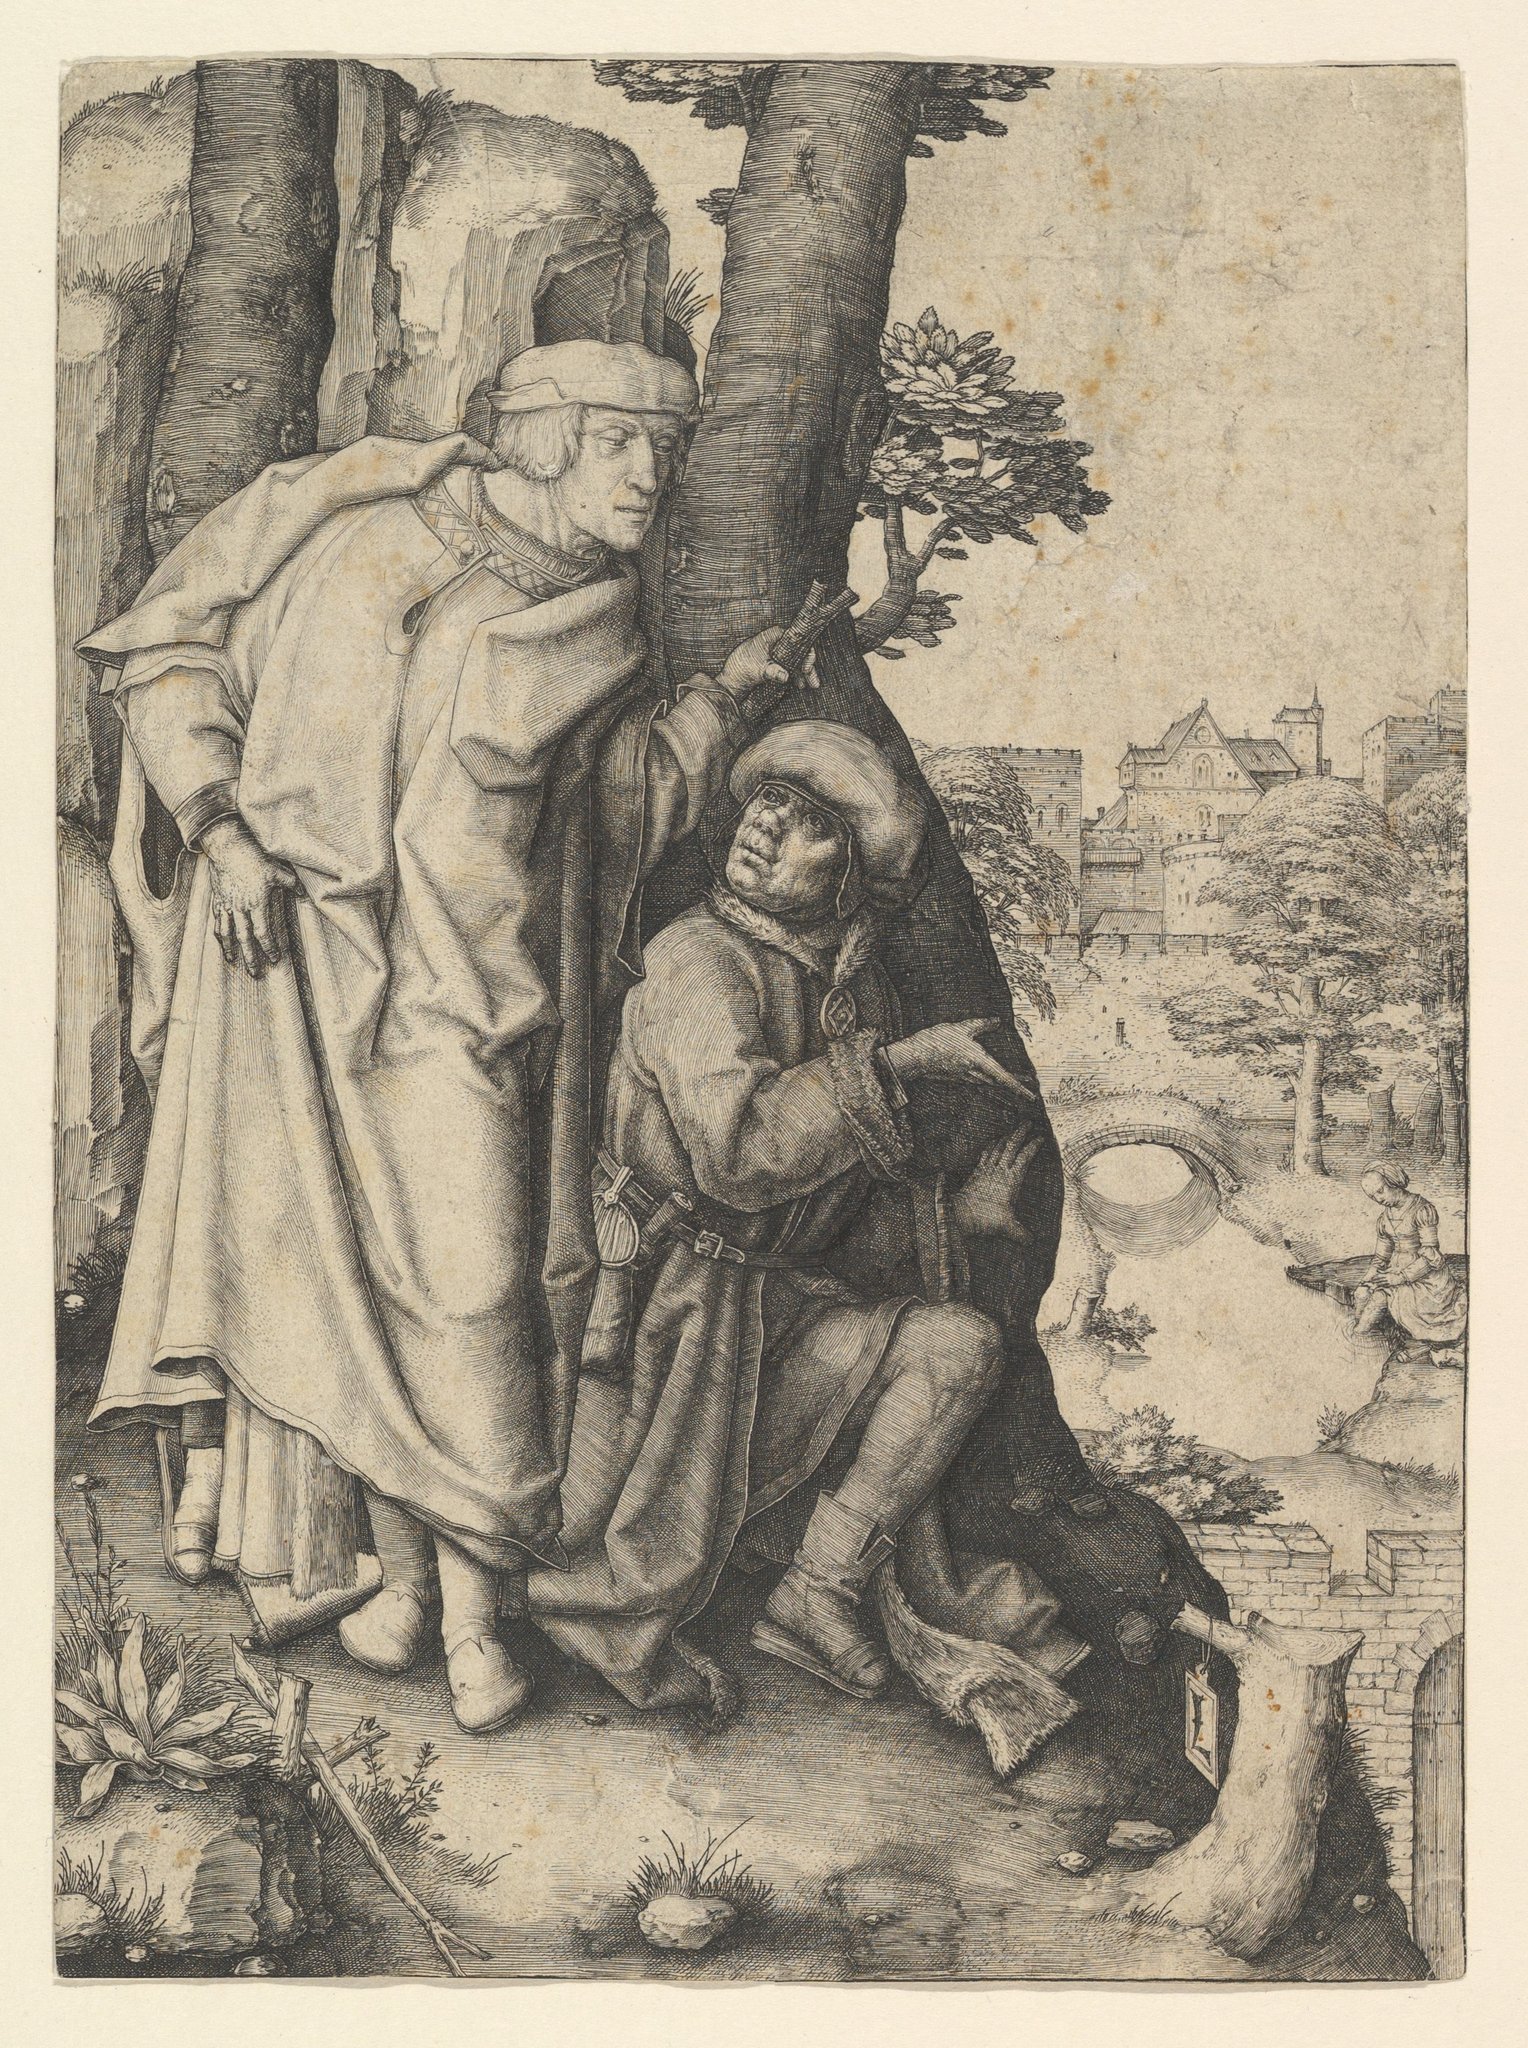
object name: print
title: Susanna and the Two Elders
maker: lucas van leyden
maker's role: artist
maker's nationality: netherlandish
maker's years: 1494-1533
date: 1508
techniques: engraving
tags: men